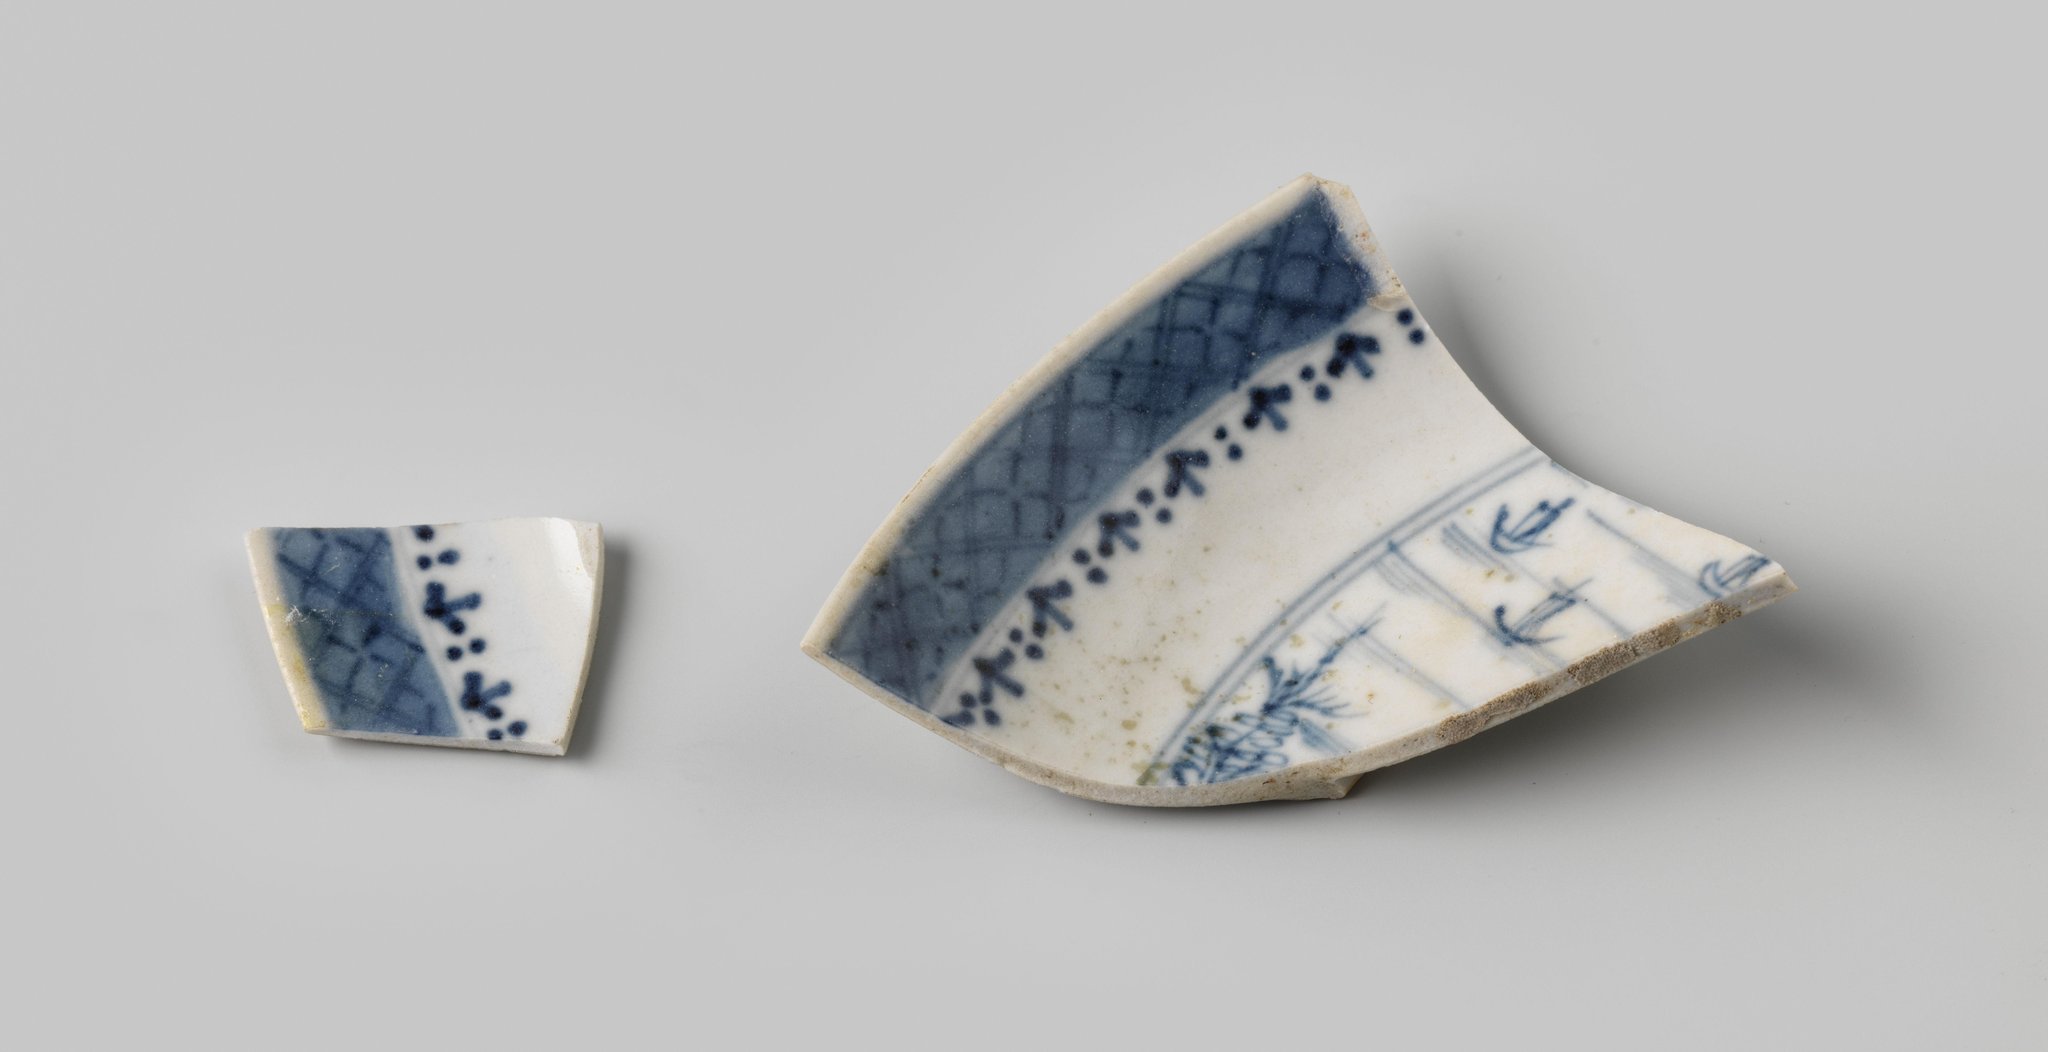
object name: bowl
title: Twee porseleinen scherven van een kom, gevonden bij V.O.C.-schip Witte Leeuw, mogelijk afkomstig van Zeelelie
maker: Anonymous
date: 1775-1800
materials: porcelain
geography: jingdezhen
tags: verenigde oostindische compagnie, sint-helena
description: Twee porseleinen scherven van een kom gevonden bij V.O.C.-schip de 'Witte Leeuw'. Dit object is 18e-eeuws en kan dus niet van de vracht van de Witte Leeuw zijn. Onduidelijk is of het object van de site komt of dat het later is vermengd, mogelijk met materiaal van de Zeelelie.